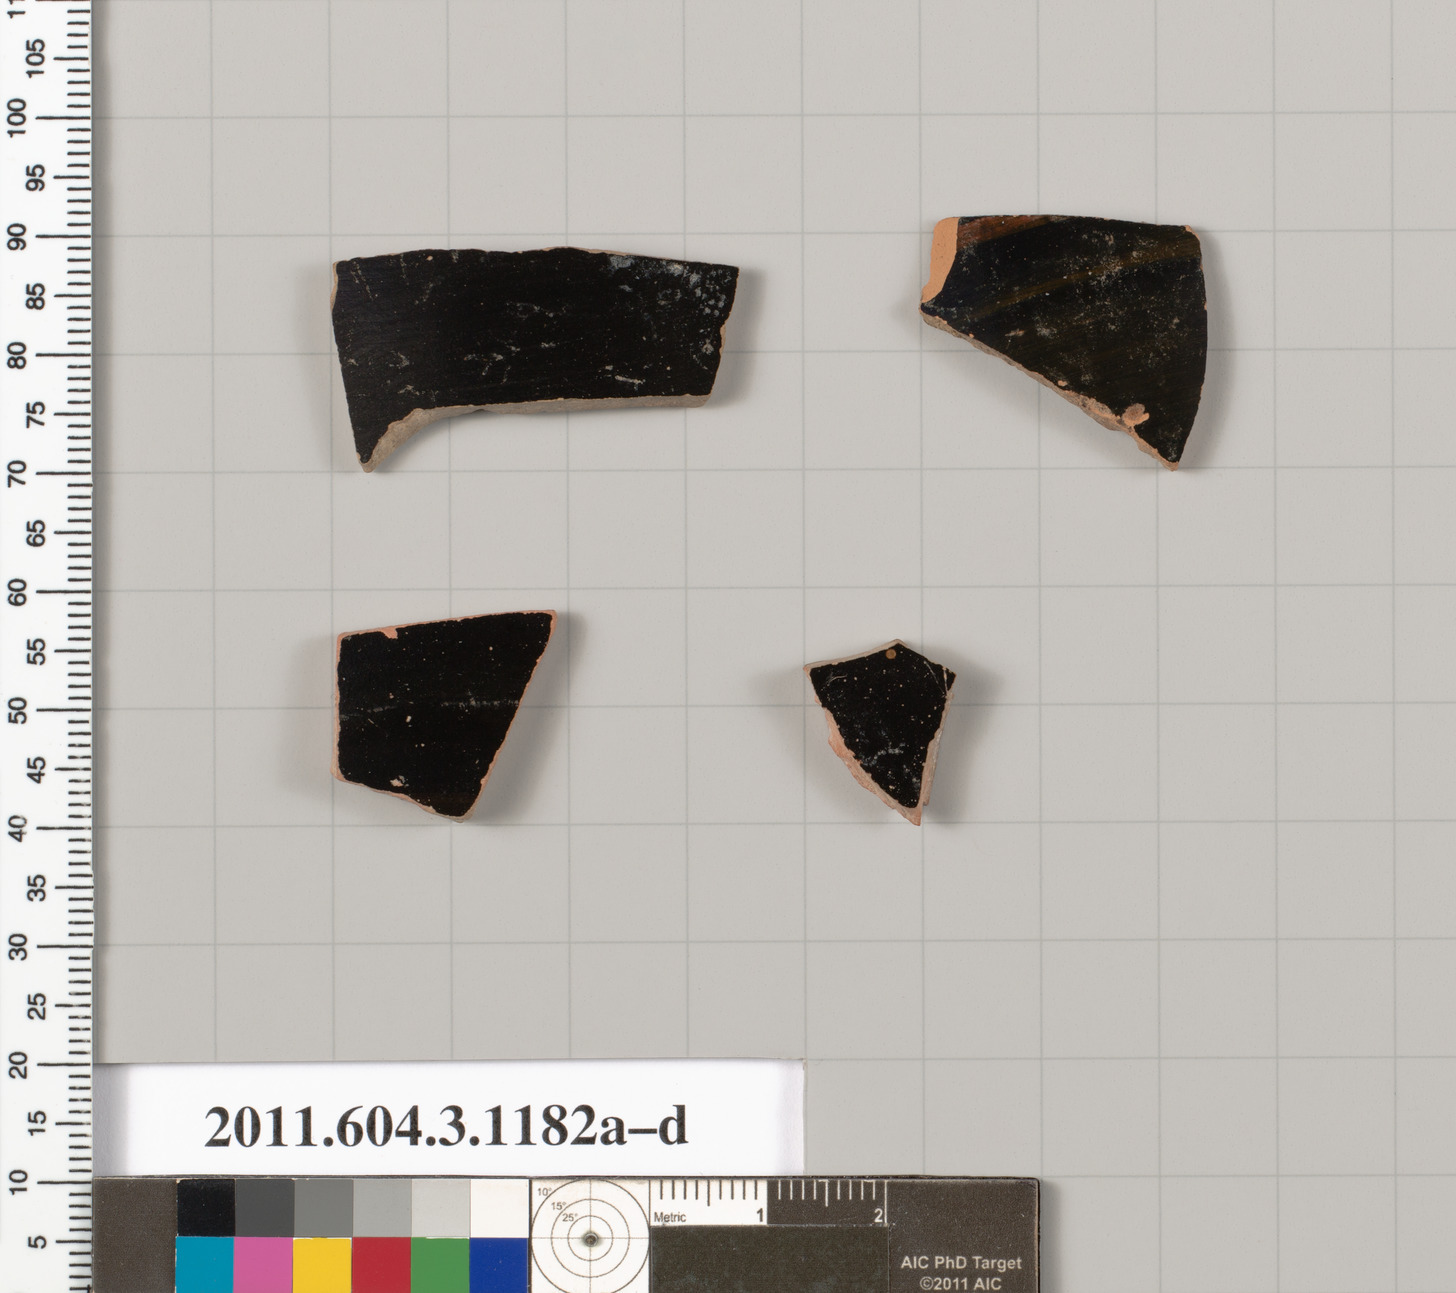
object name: mastoid or kyathos fragment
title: Terracotta fragments of mastoids (drinking cups with narrow base) or kyathoi (cup-shaped ladles)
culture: greek, attic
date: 534-468 BCE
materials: terracotta